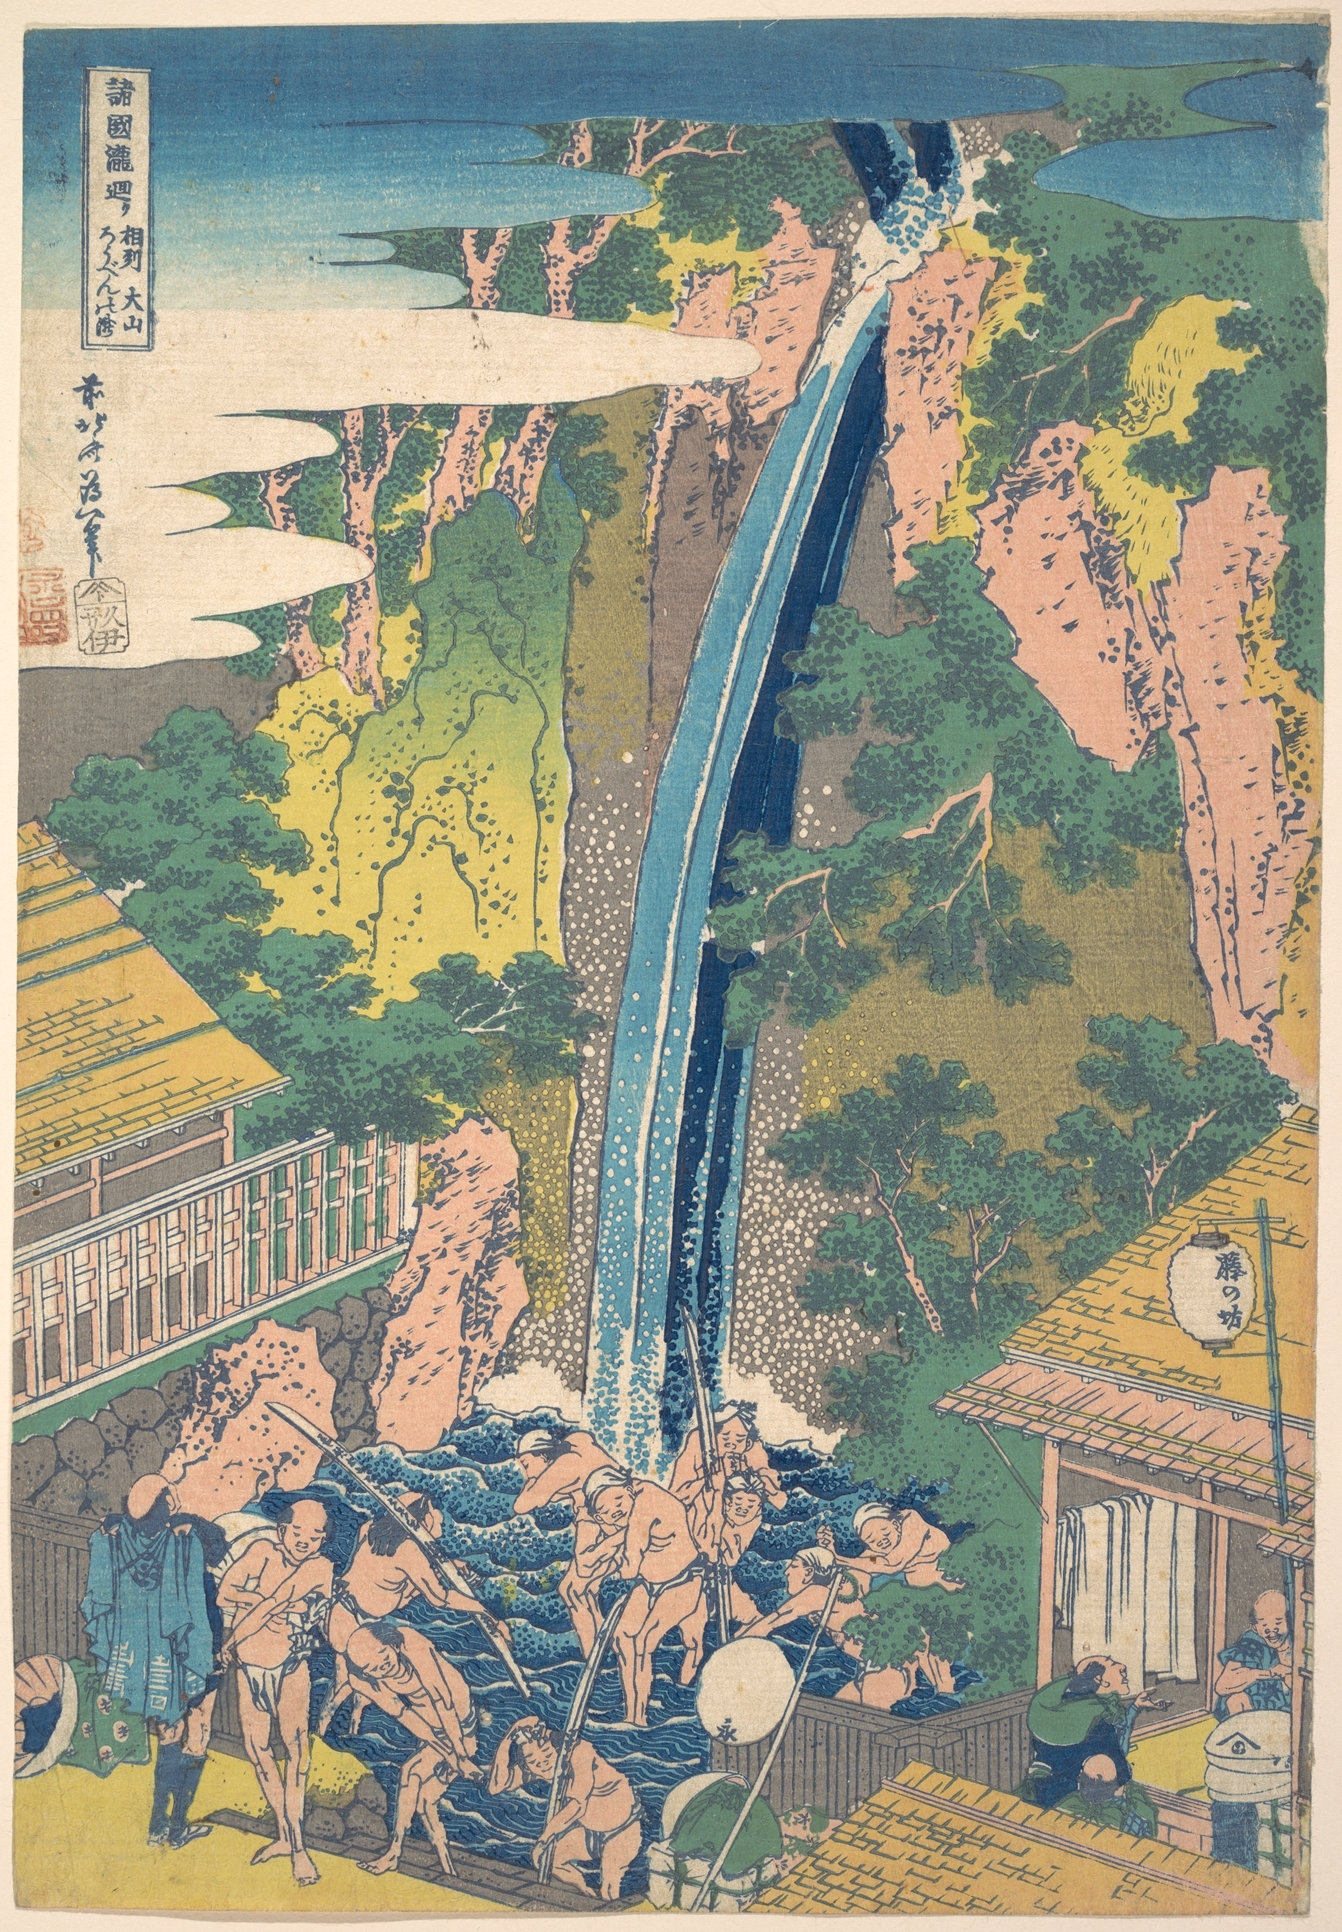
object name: woodblock print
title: Rōben Waterfall at Ōyama in Sagami Province (Sōshū Ōyama Rōben no taki), from the series A Tour of Waterfalls in Various Provinces (Shokoku taki meguri)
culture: japanese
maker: katsushika hokusai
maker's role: artist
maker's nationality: japanese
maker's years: 1760-1849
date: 1760-1849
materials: ink, paper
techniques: woodblock print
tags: men,waterfalls,trees